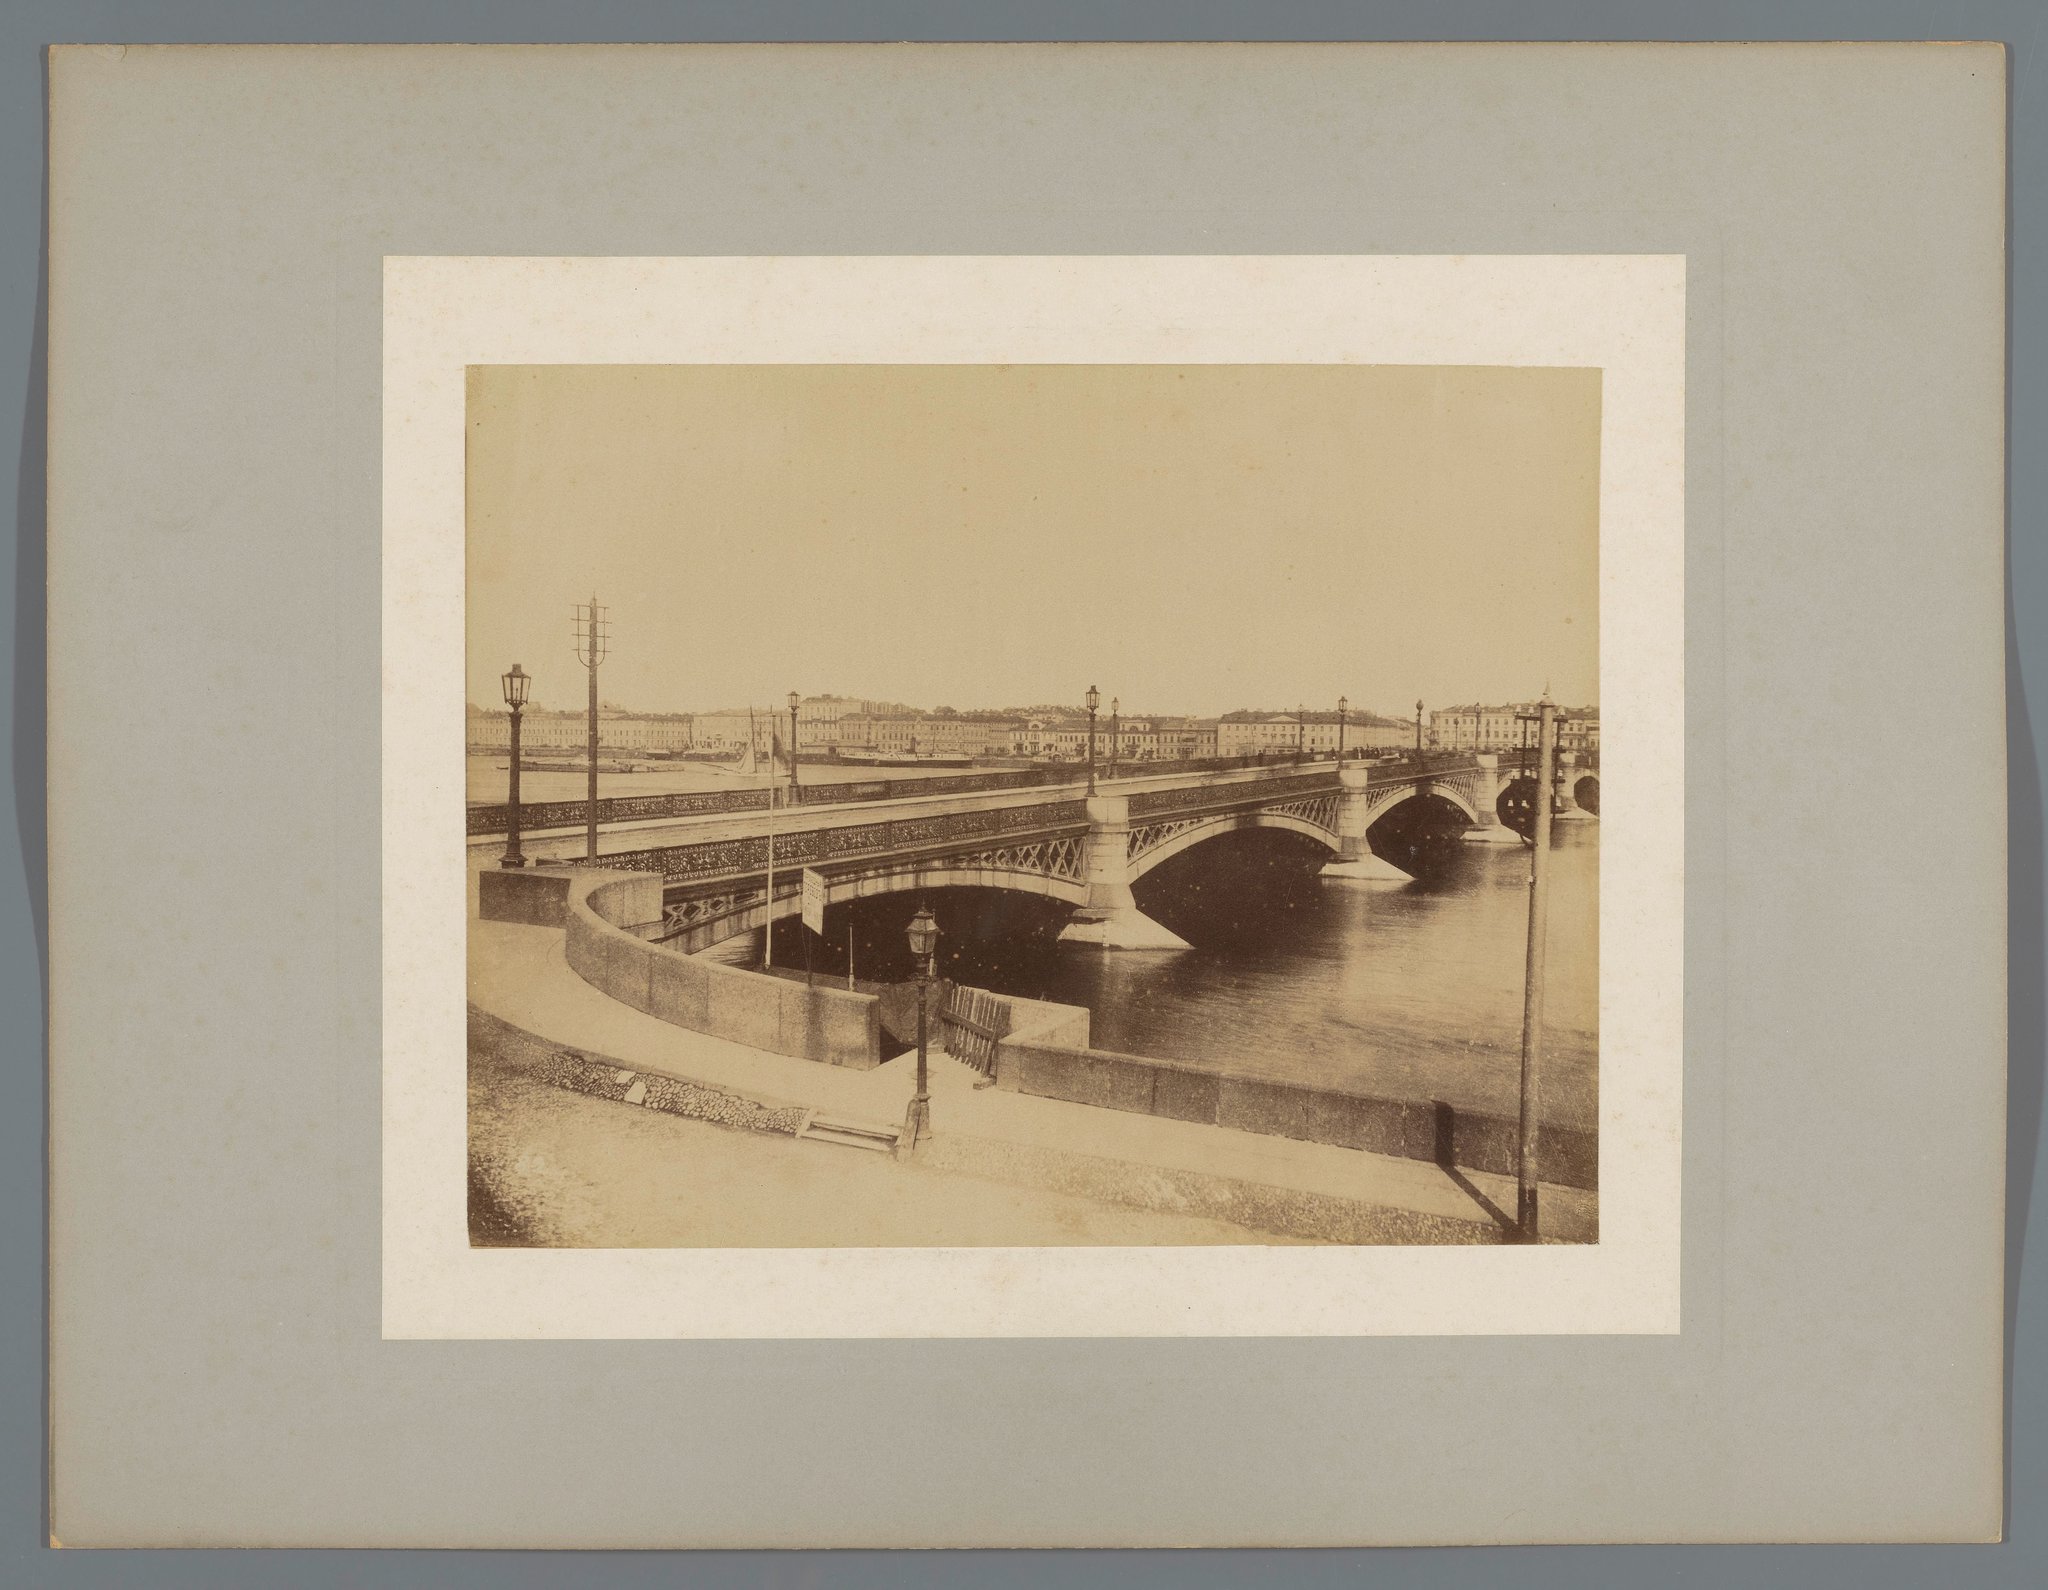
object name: photograph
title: Nicolaasbrug, St. Petersburg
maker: Anonymous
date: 1860-1890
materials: cardboard, paper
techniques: albumen print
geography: sint-petersburg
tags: bridge in city across river, canal, etc., annunciation bridge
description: Tegenwoordig heet de Nikolaevsky brug de Blagovesjtsjenskiy brug.